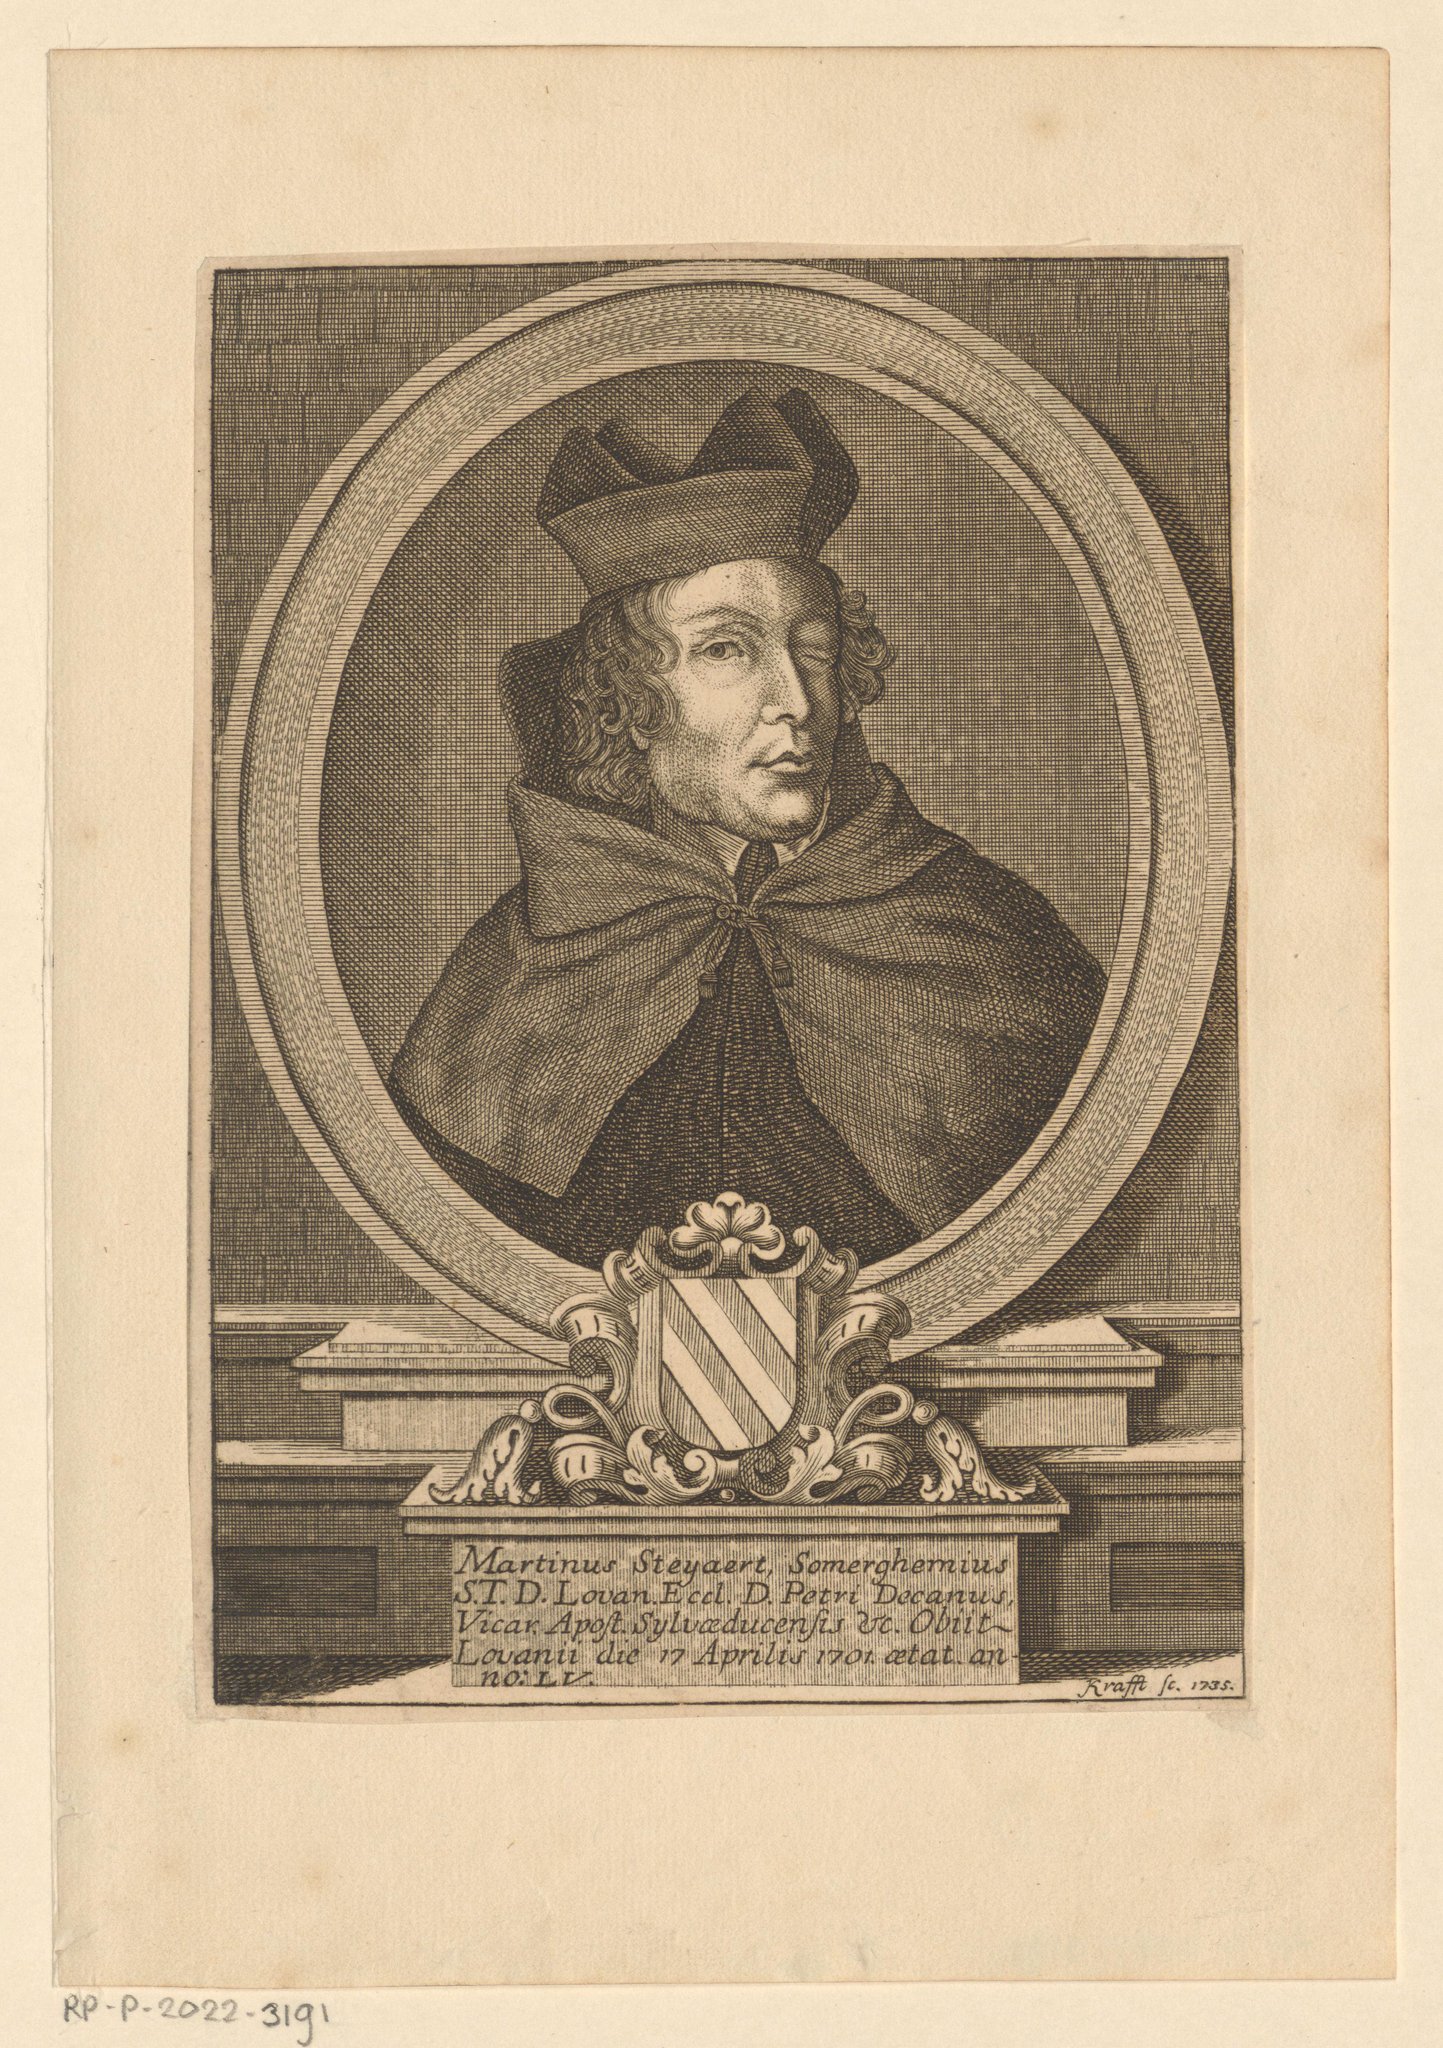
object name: print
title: Portret van Martinus Steyaert op 55-jarige leeftijd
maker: jan lauwryn krafft (i)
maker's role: print maker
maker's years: 1694-1785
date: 1735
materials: paper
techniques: engraving, etching, snipping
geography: southern netherlands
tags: louvain, theologian, historical persons, functionaries and dignitaries (with name) ~ episcopal protestant churches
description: Met vierregelig onderschrift in het Latijn.